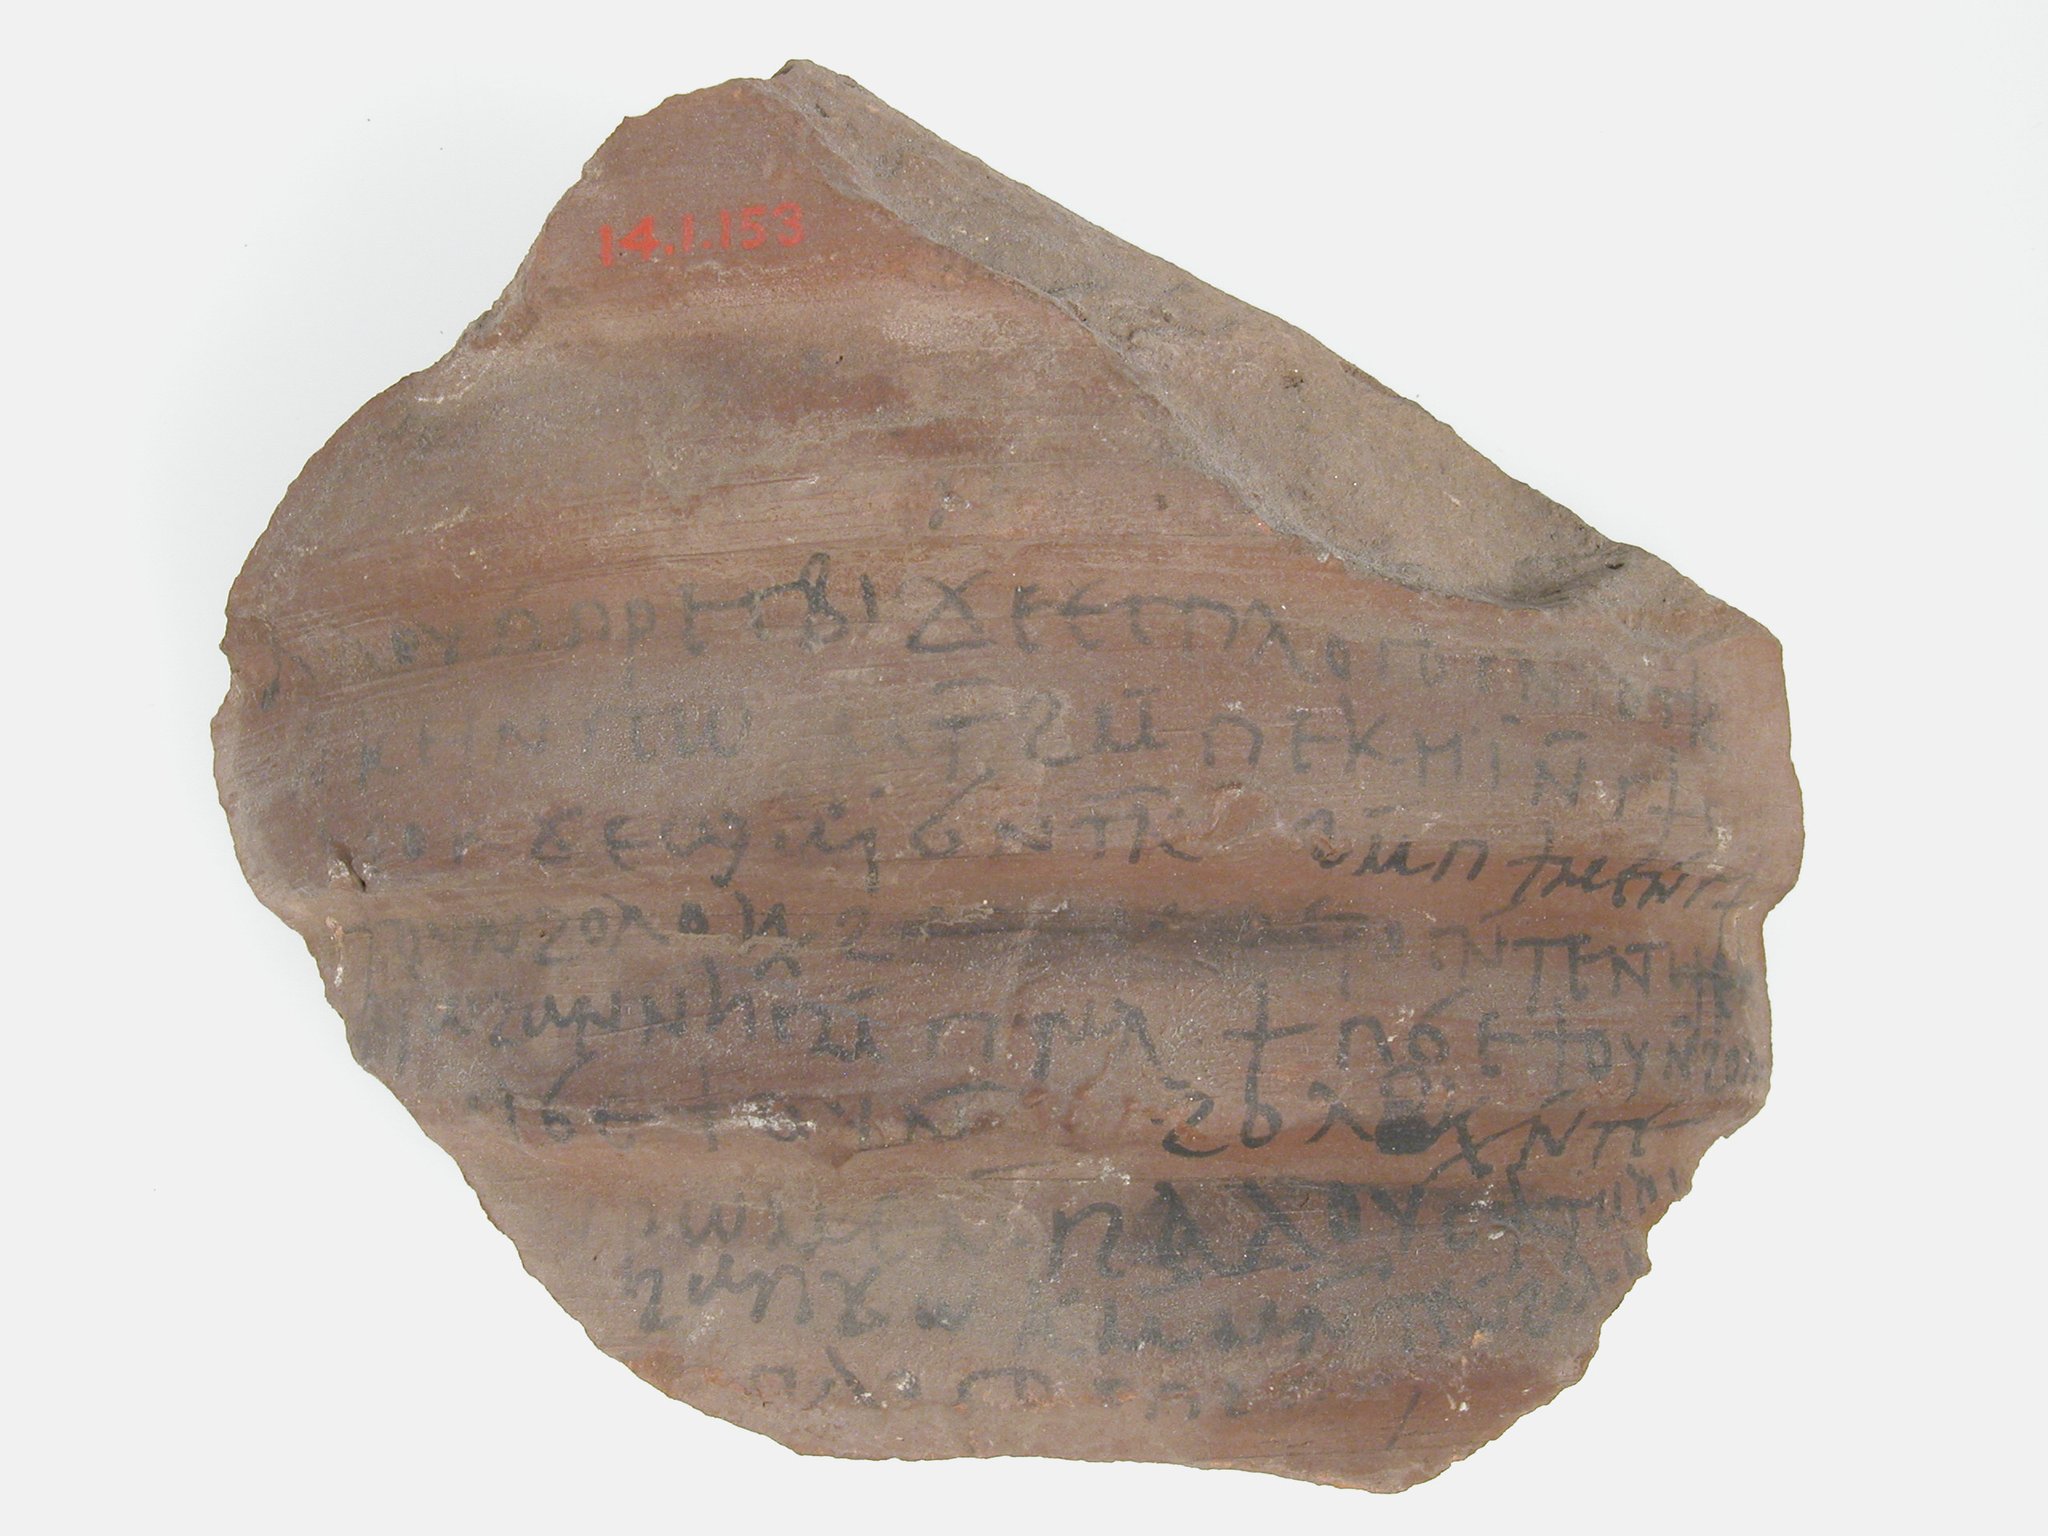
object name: ostrakon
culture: coptic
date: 600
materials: ink, pottery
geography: egypt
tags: coptic,documents